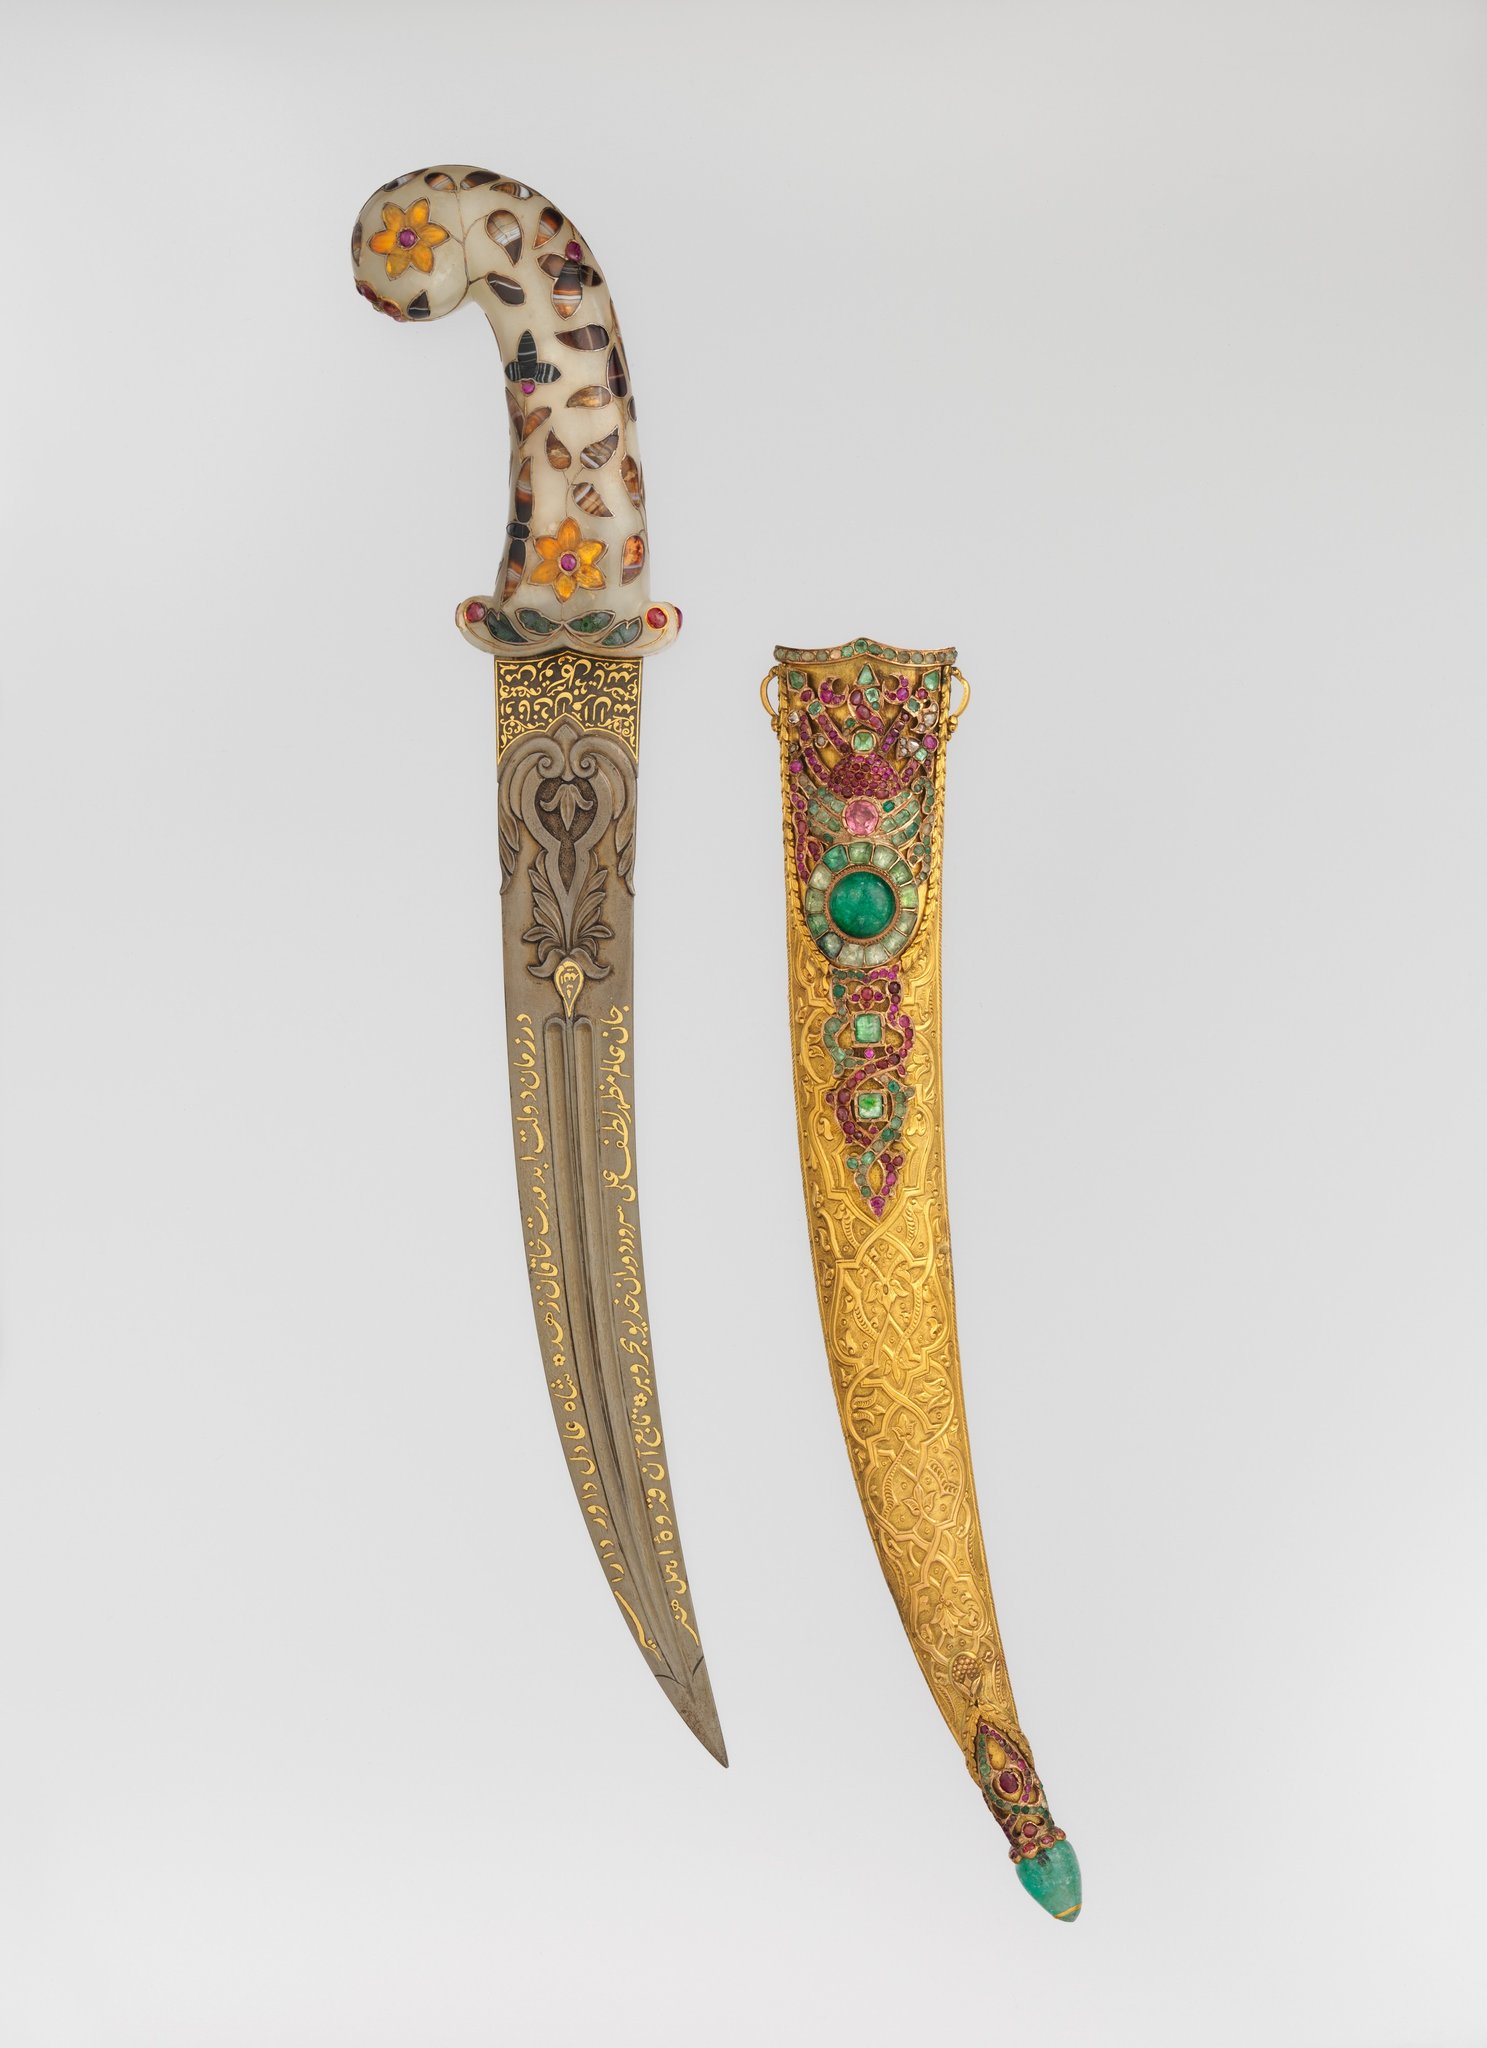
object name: dagger with scabbard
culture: blade and scabbard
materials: stone, copper, gold, jade, silver, steel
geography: india